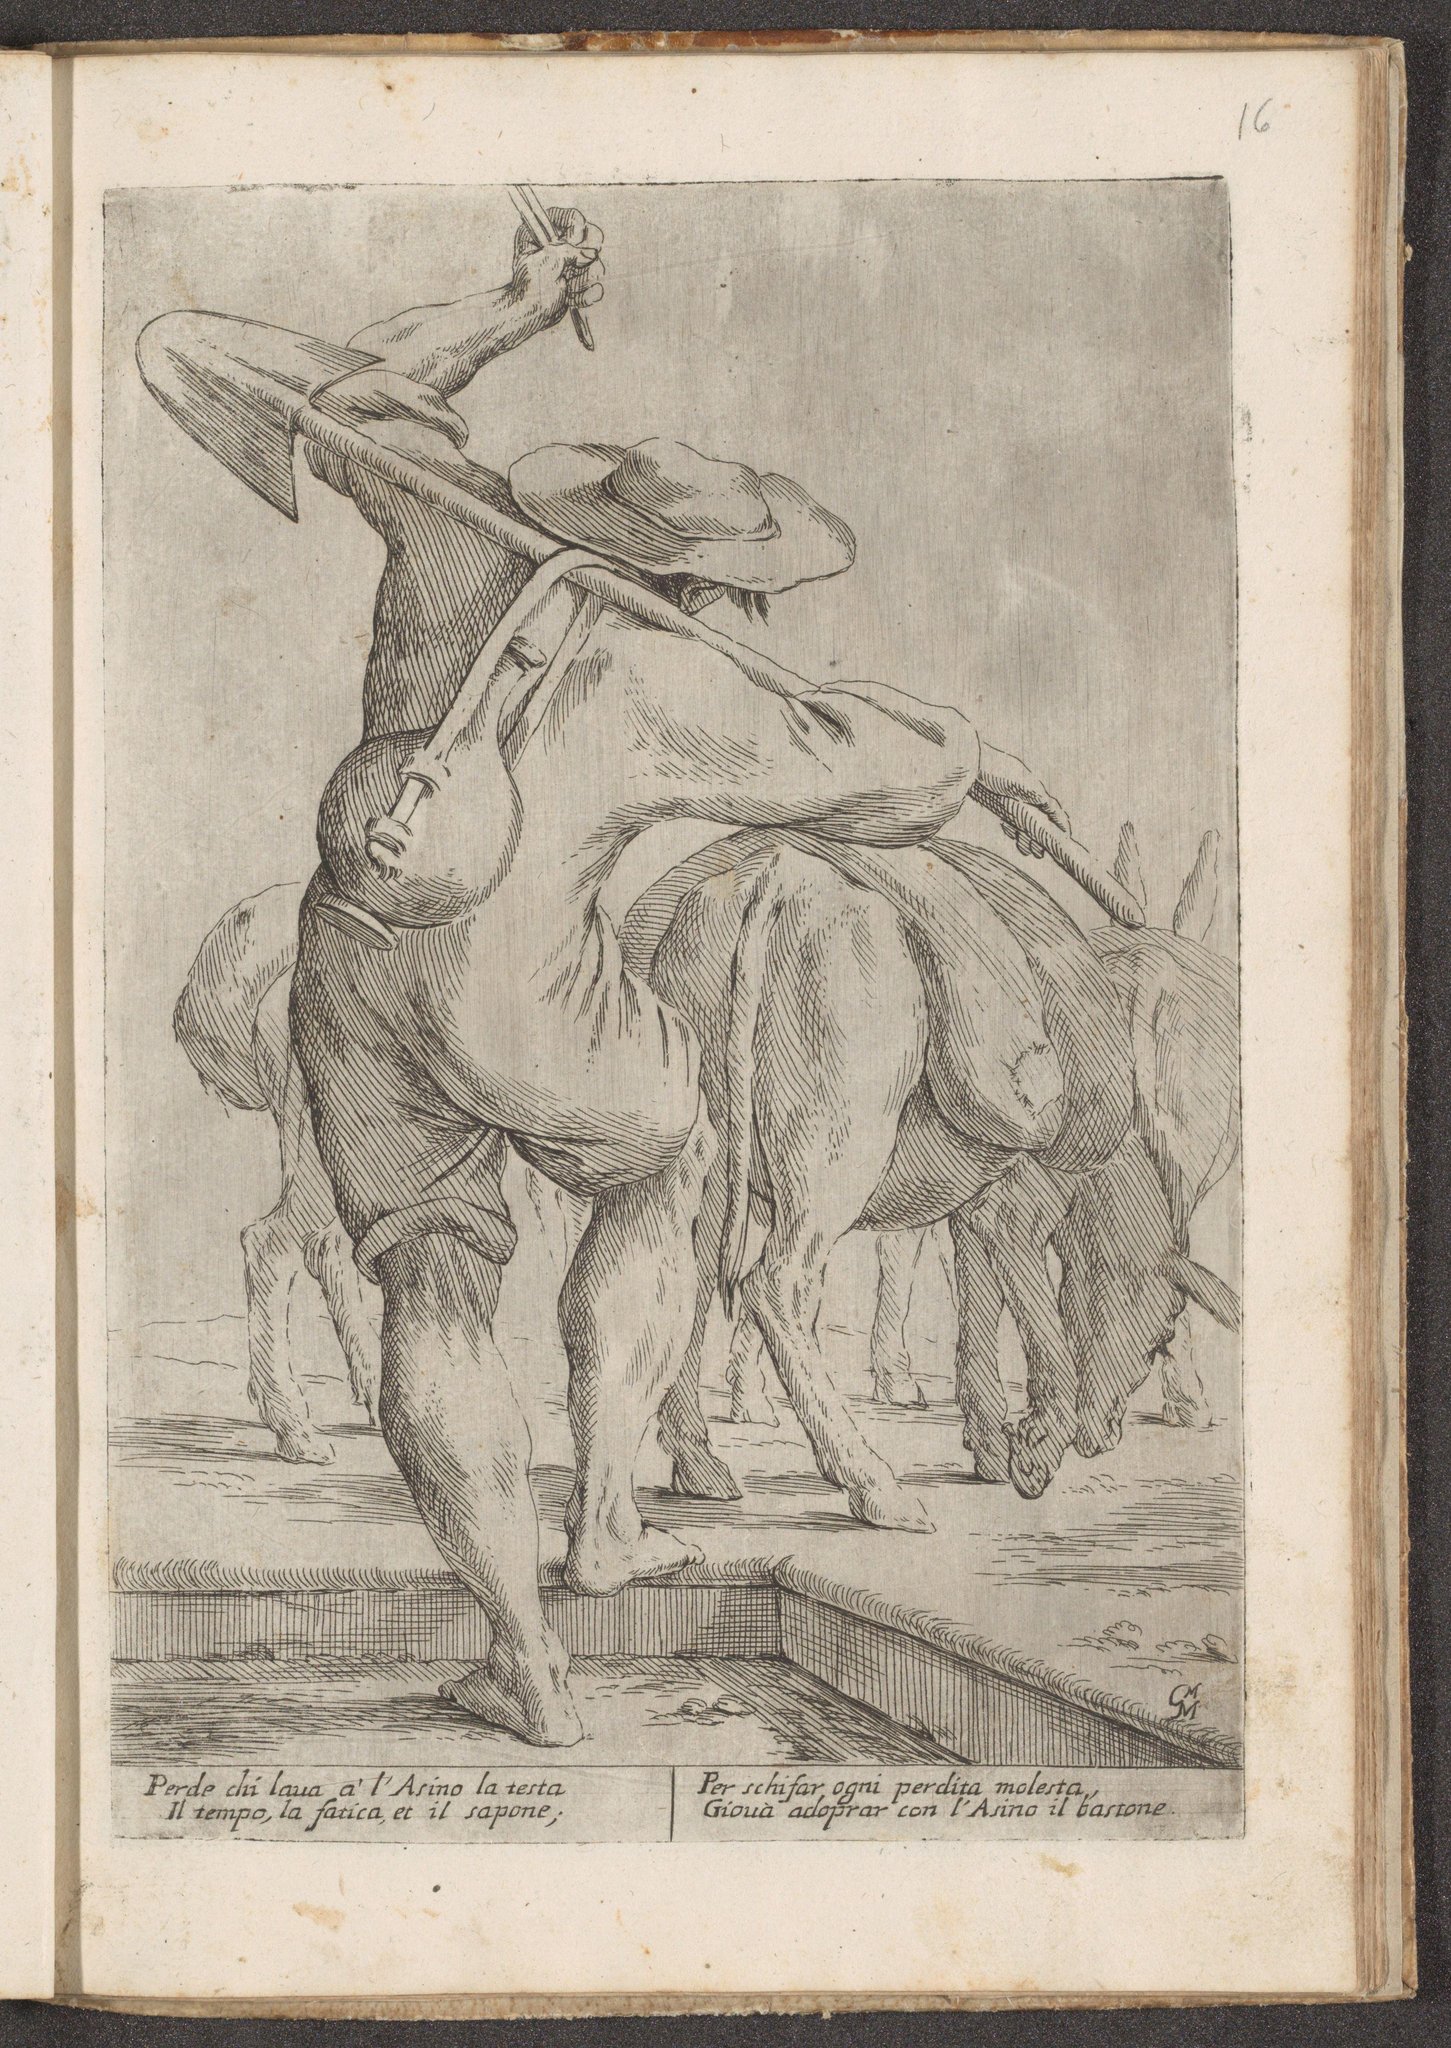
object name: print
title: L'Arti Per Via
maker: giuseppe maria mitelli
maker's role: draughtsman, painter, print maker, publisher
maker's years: 1634-1718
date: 1660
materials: paper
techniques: etching, intaglio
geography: bologna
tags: ass, donkey, street-trader, cattle driving, cattle driver, 'cris de paris', cries of london, etc., whip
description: Man met een kruik aan een schep over zijn schouder en een zweep in de hand, op de rug gezien. Hij drijft een paar beladen ezels voor zich uit. Italiaans vers in ondermarge. De prent maakt deel uit van een album.